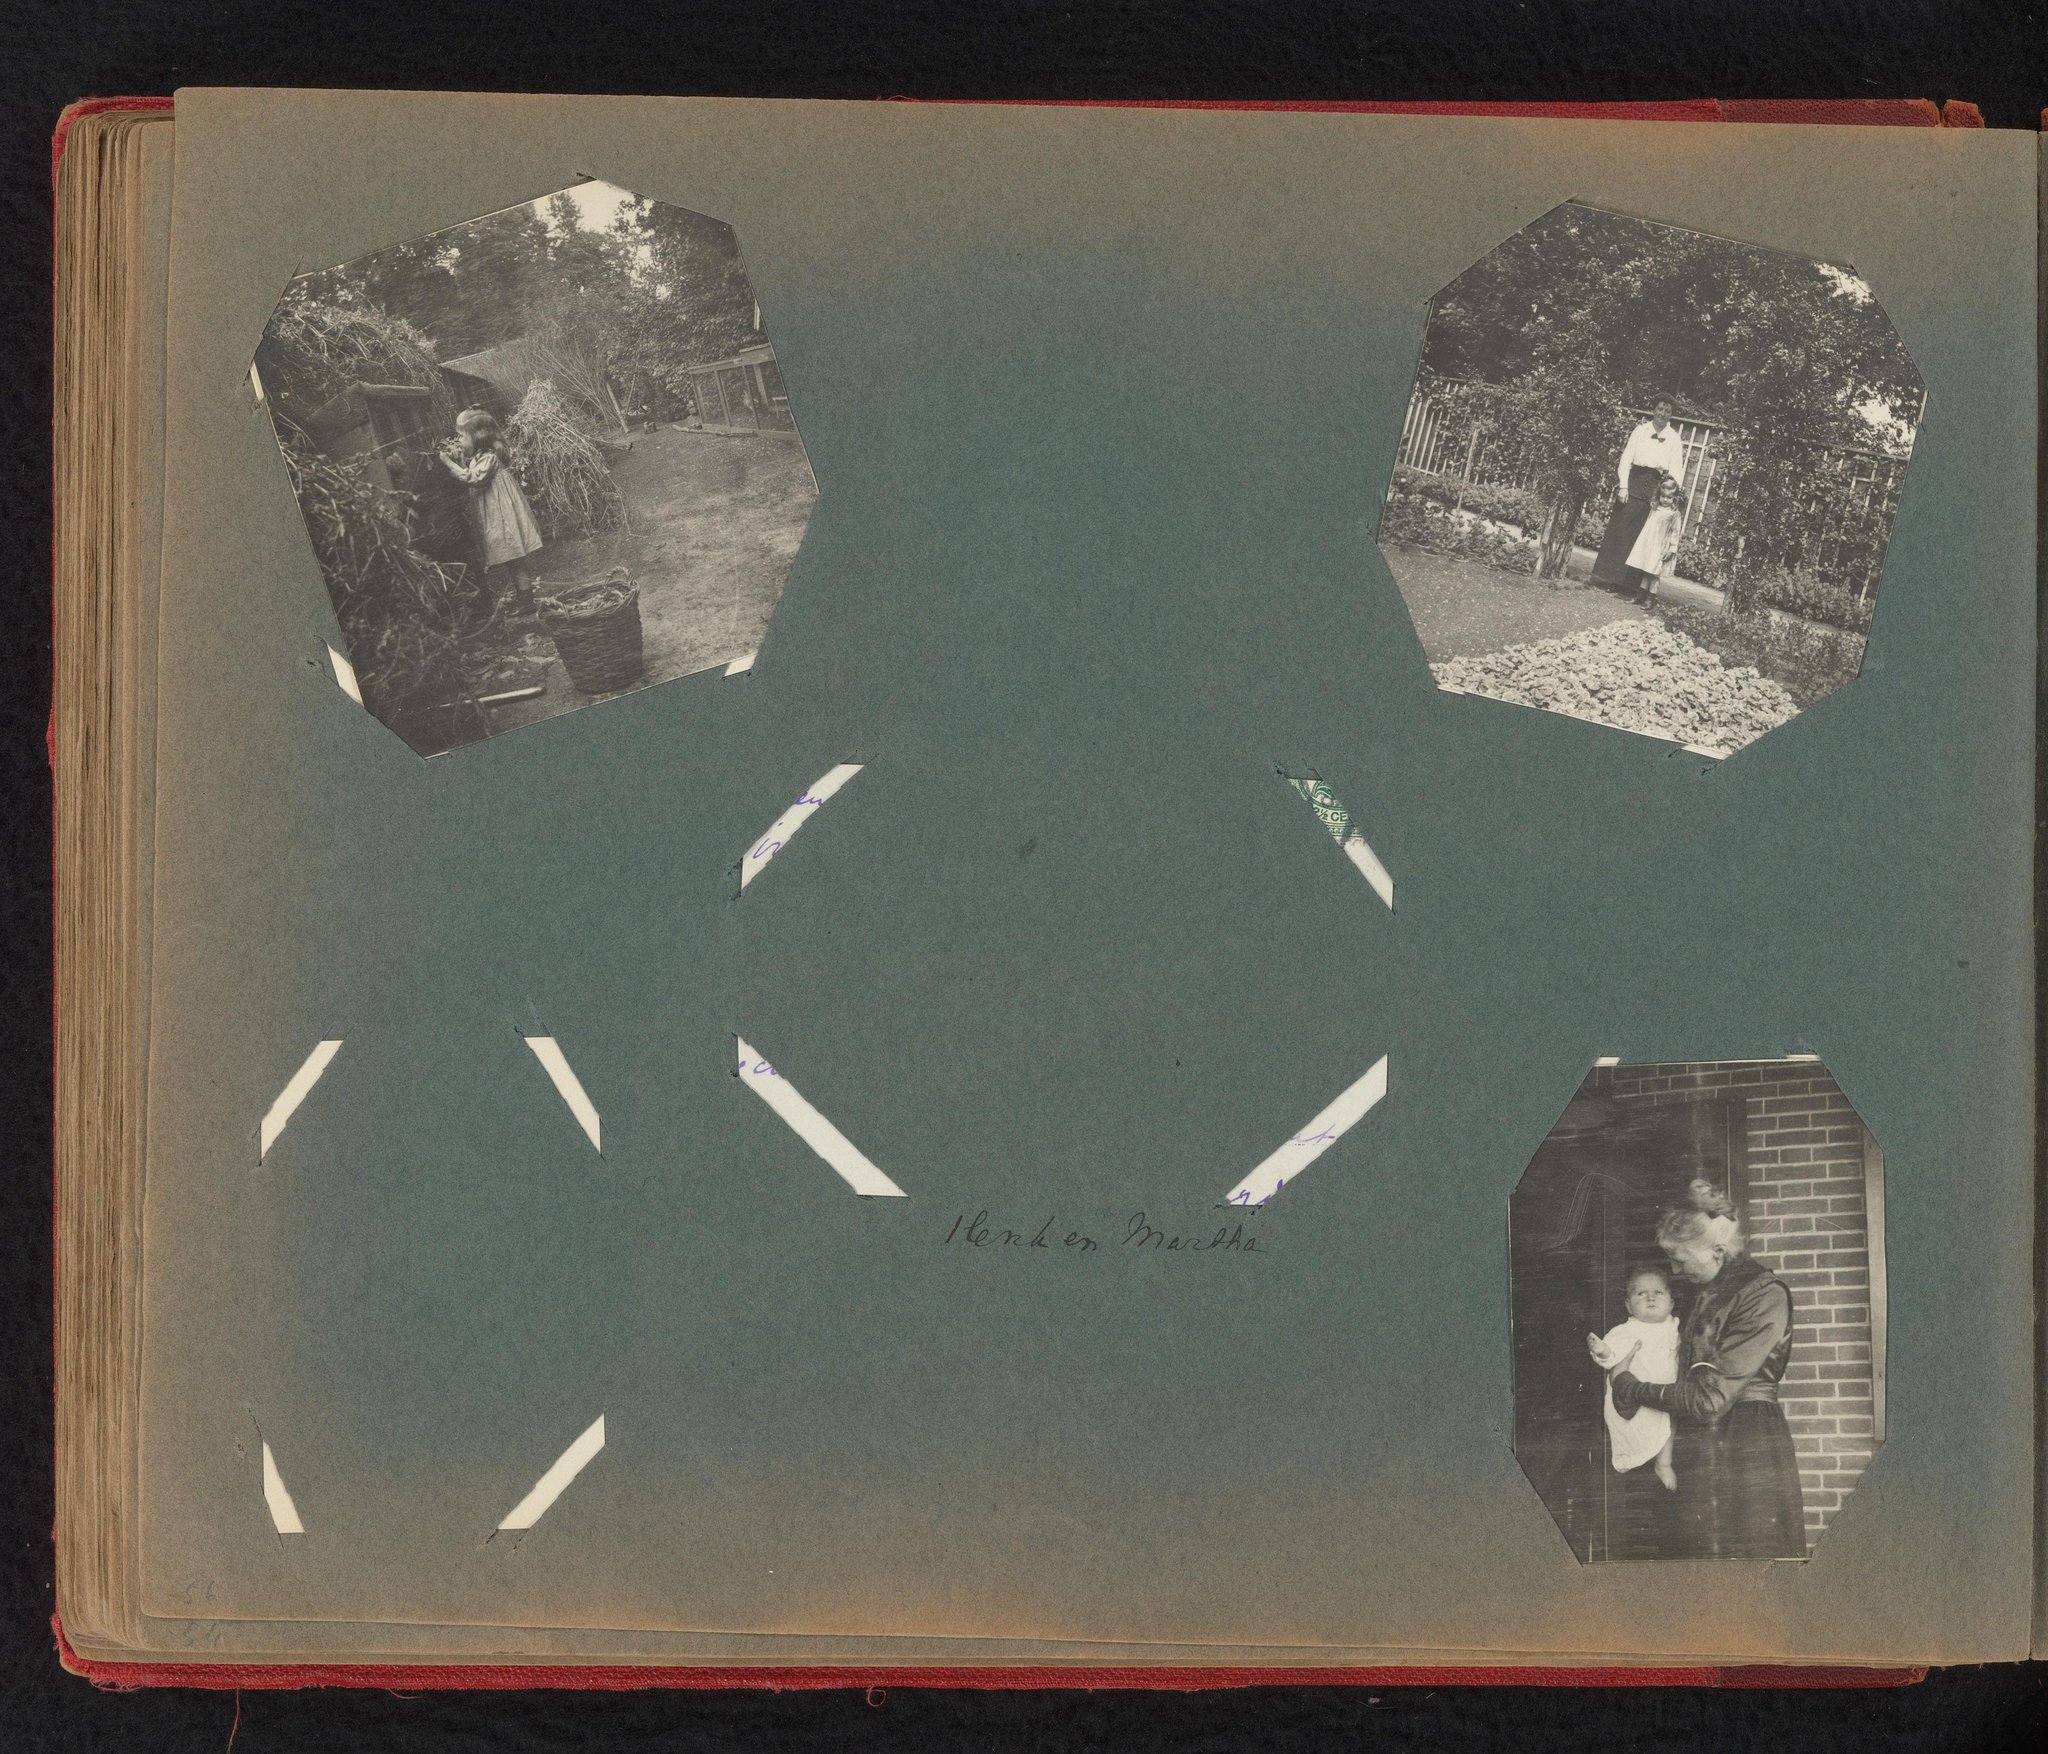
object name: photograph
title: Twee taferelen met Eva Boelen in een tuin, en Eva Boelen-Smidt van Gelder met een baby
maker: charlotte alida boelen-matthes (lot)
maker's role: amateurfotograaf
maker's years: 1889-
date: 1915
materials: paper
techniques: gelatin silver print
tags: amsterdam, eva charlotte pennink-boelen, garden, girl (child between toddler and youth)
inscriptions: inscription: ‘Henk en Martha’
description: Deze foto's zijn onderdeel van een album.